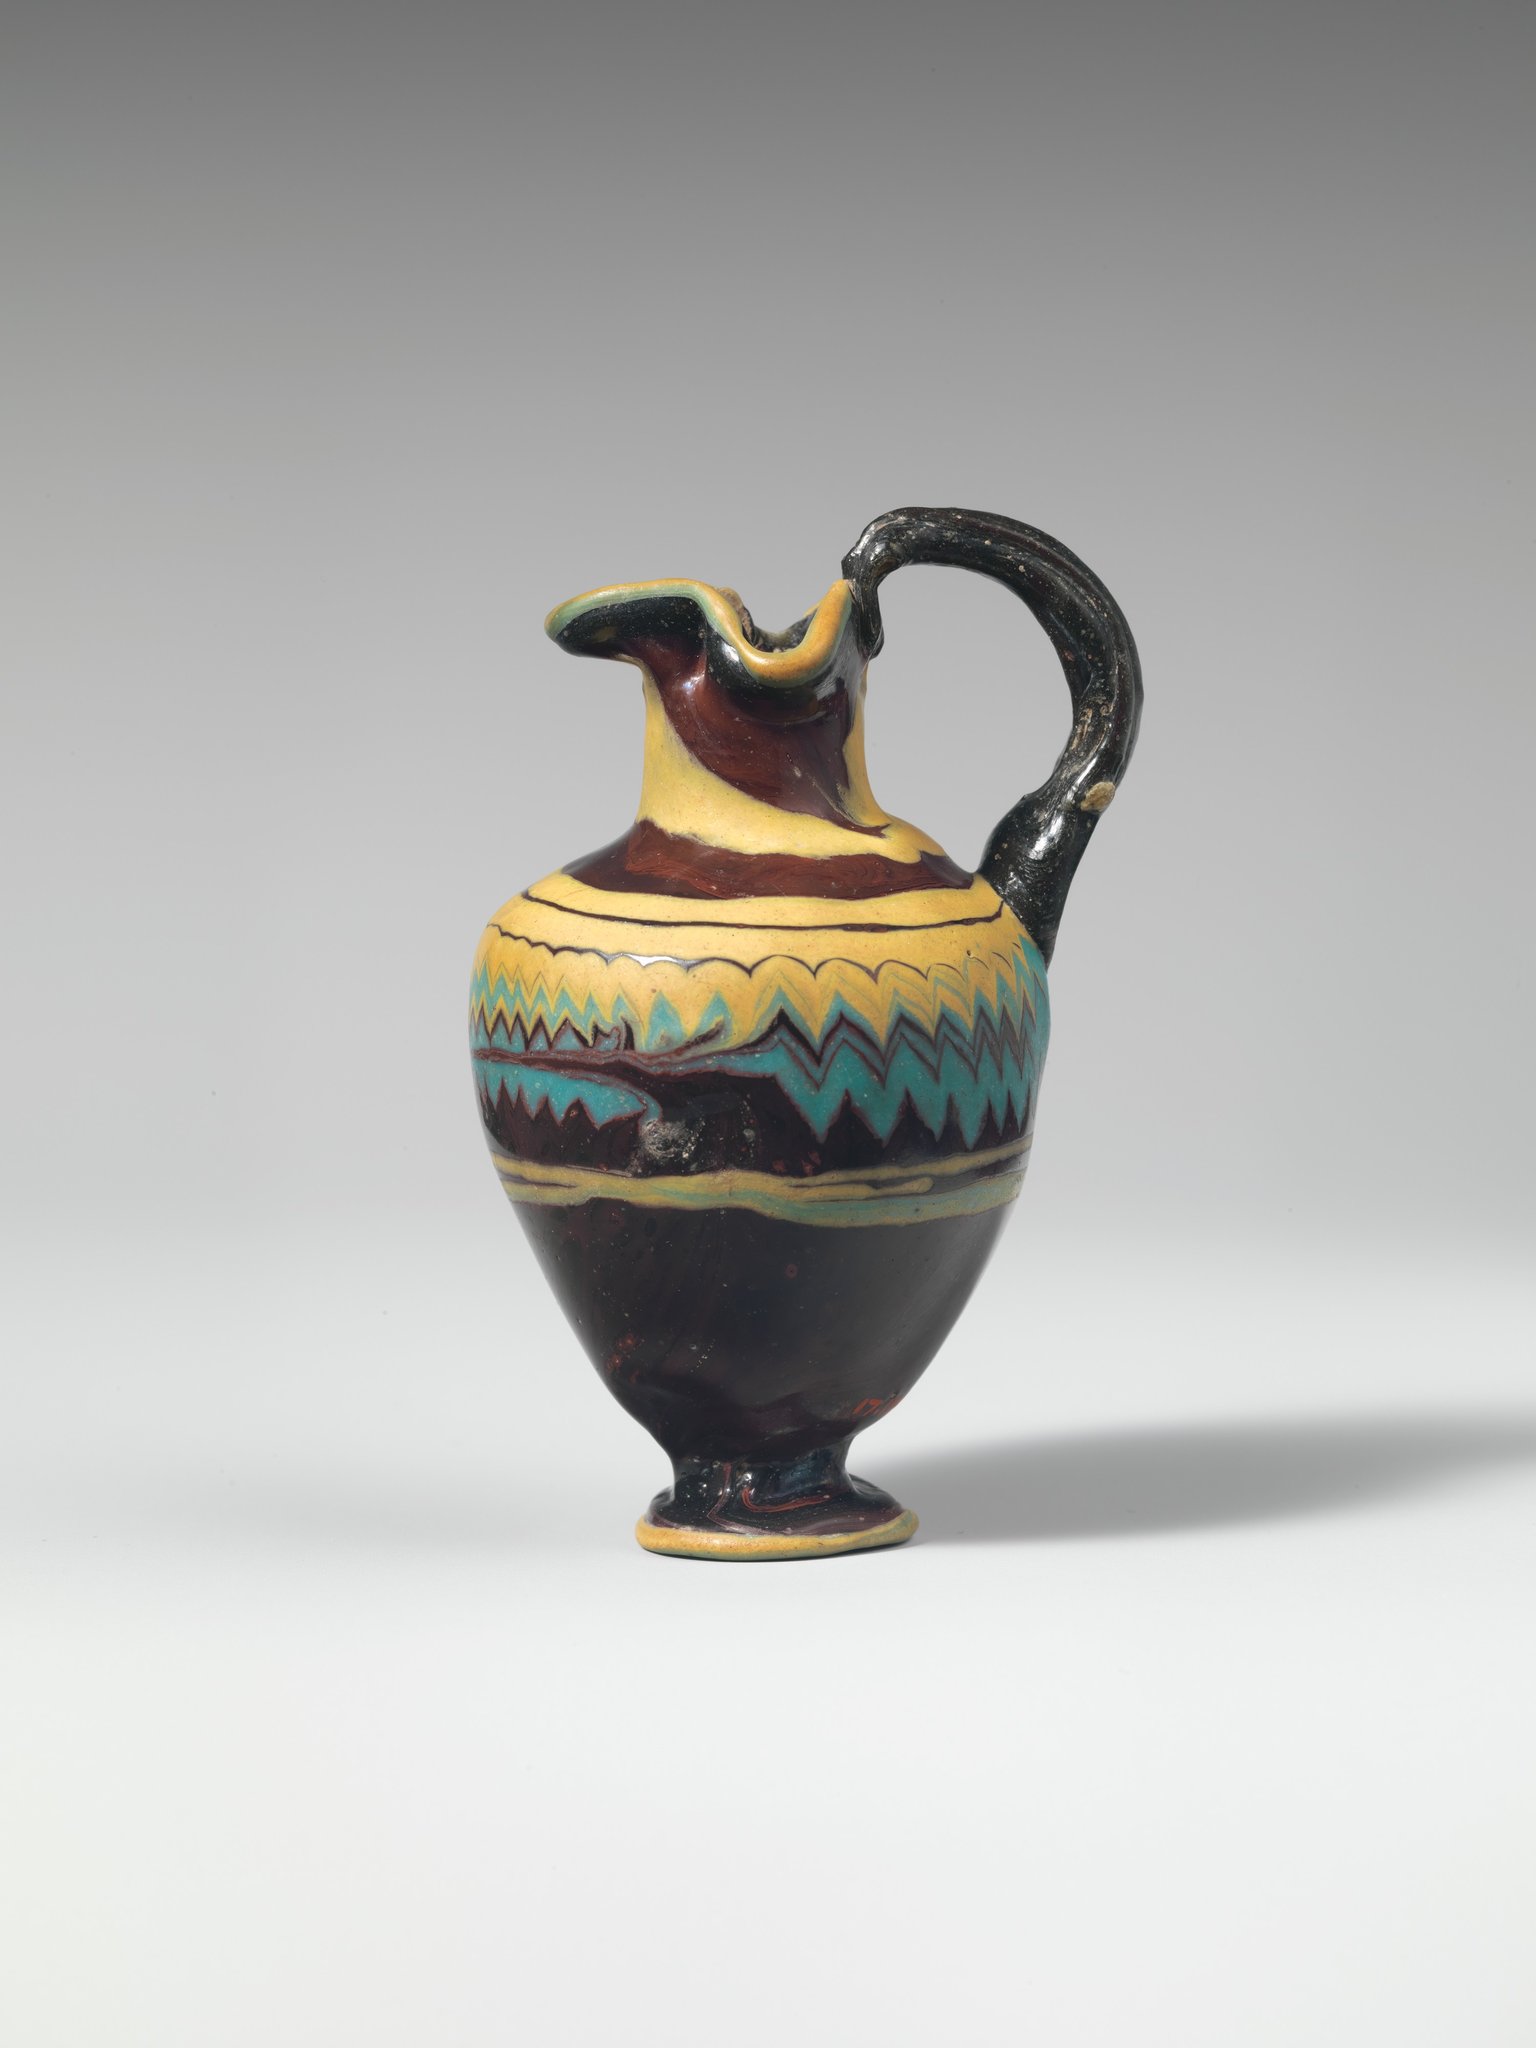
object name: oinochoe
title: Glass oinochoe (perfume jug)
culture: greek, eastern mediterranean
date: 500-401 BCE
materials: glass